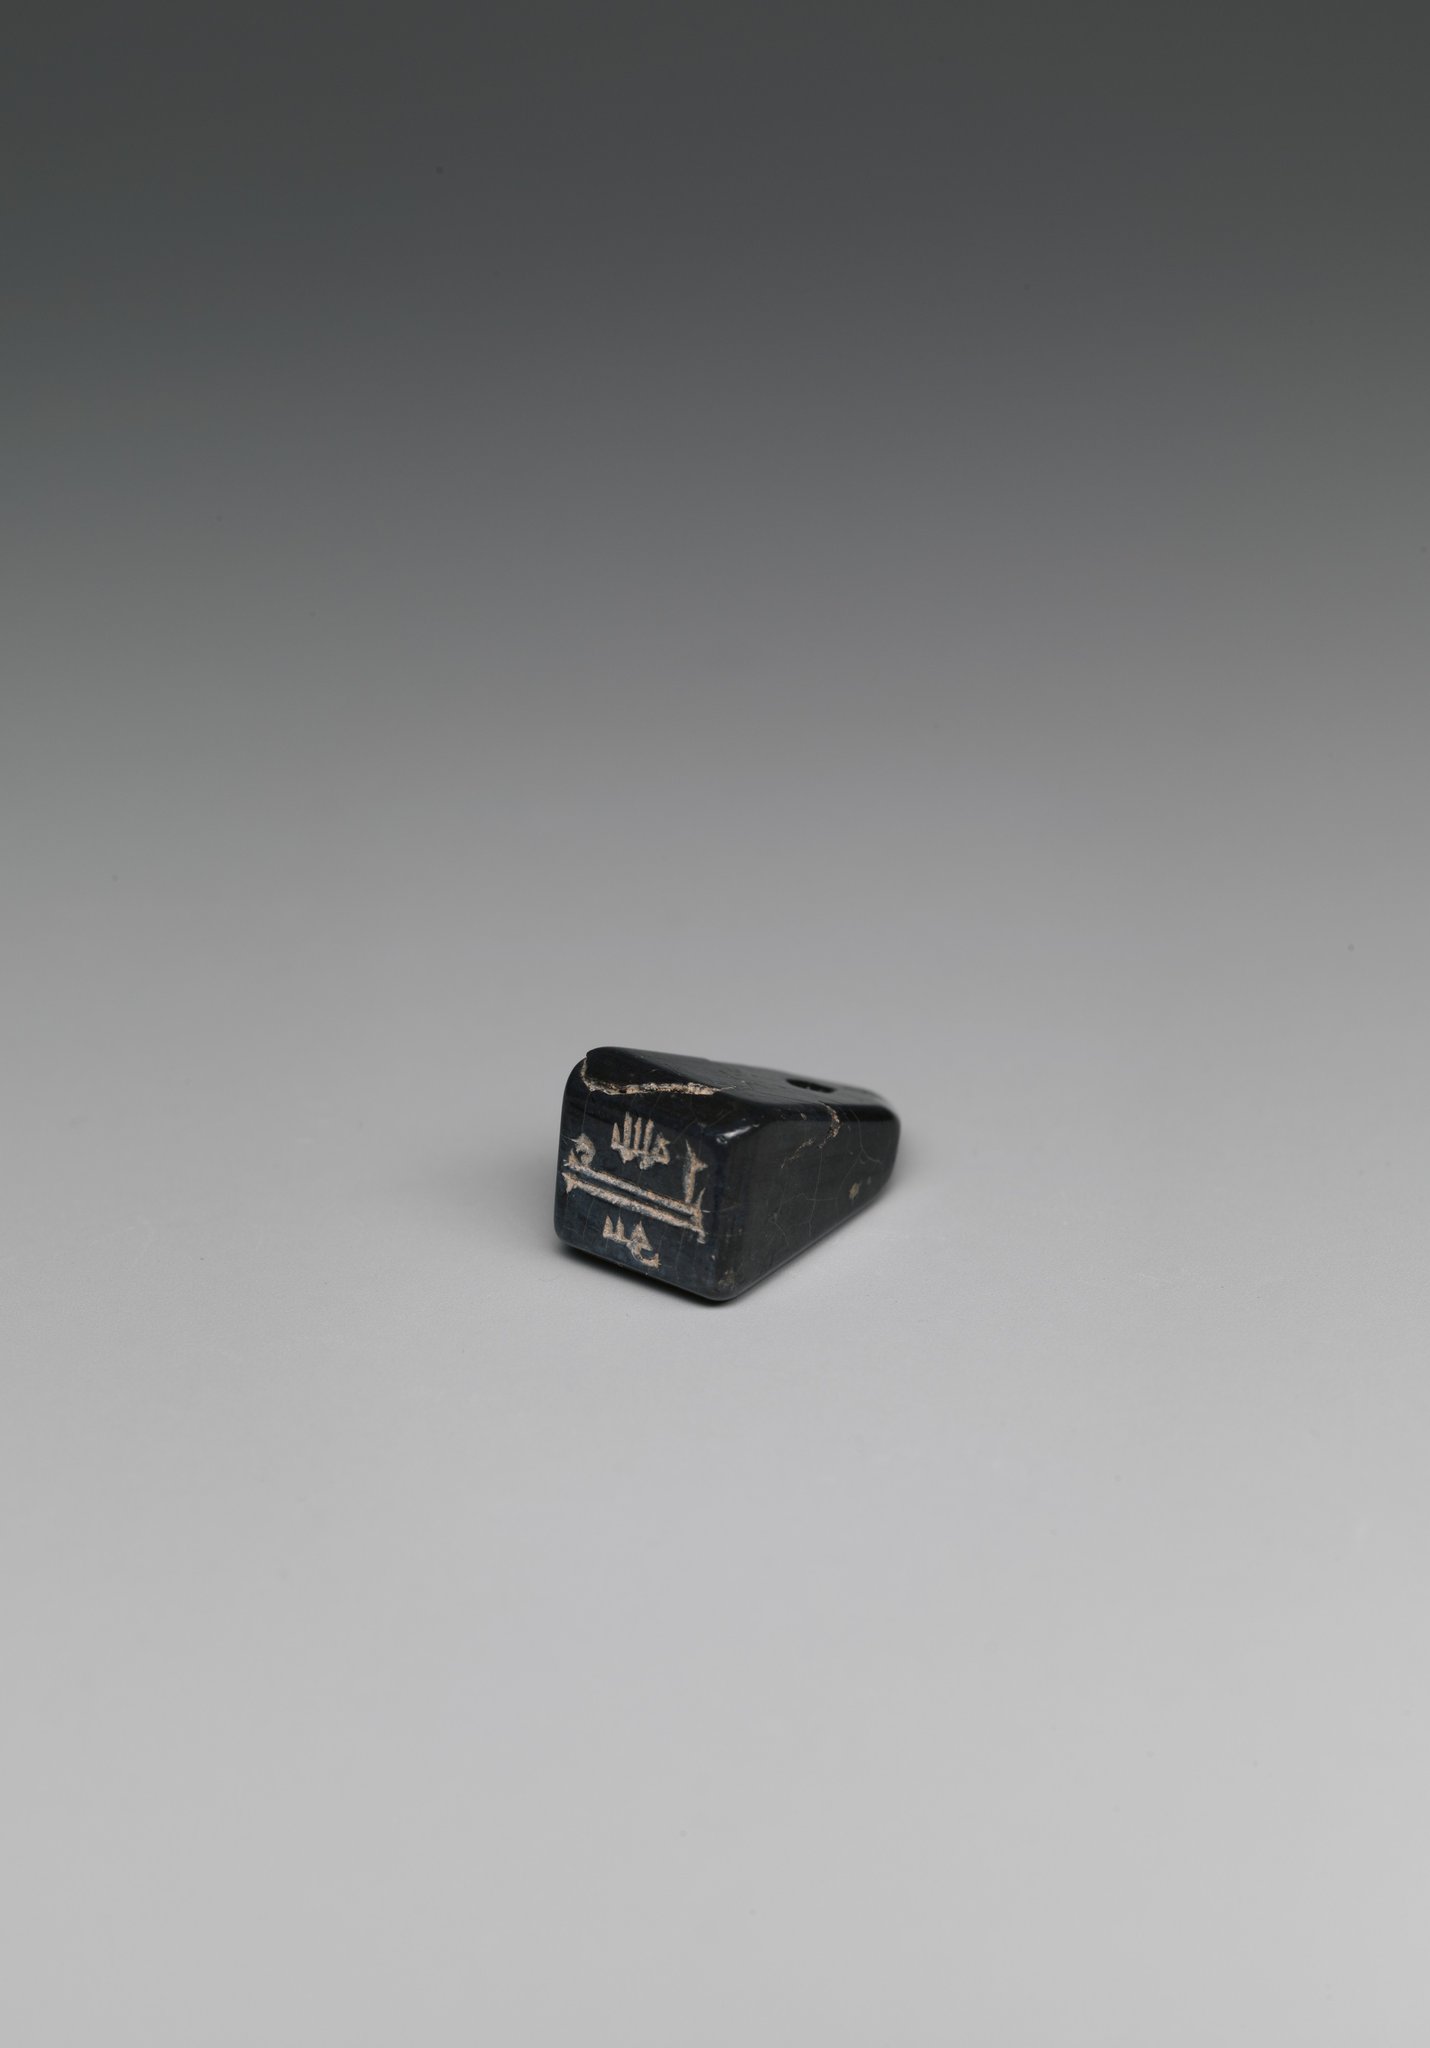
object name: seal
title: Inscribed Seal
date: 901-1100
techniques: incising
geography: iran